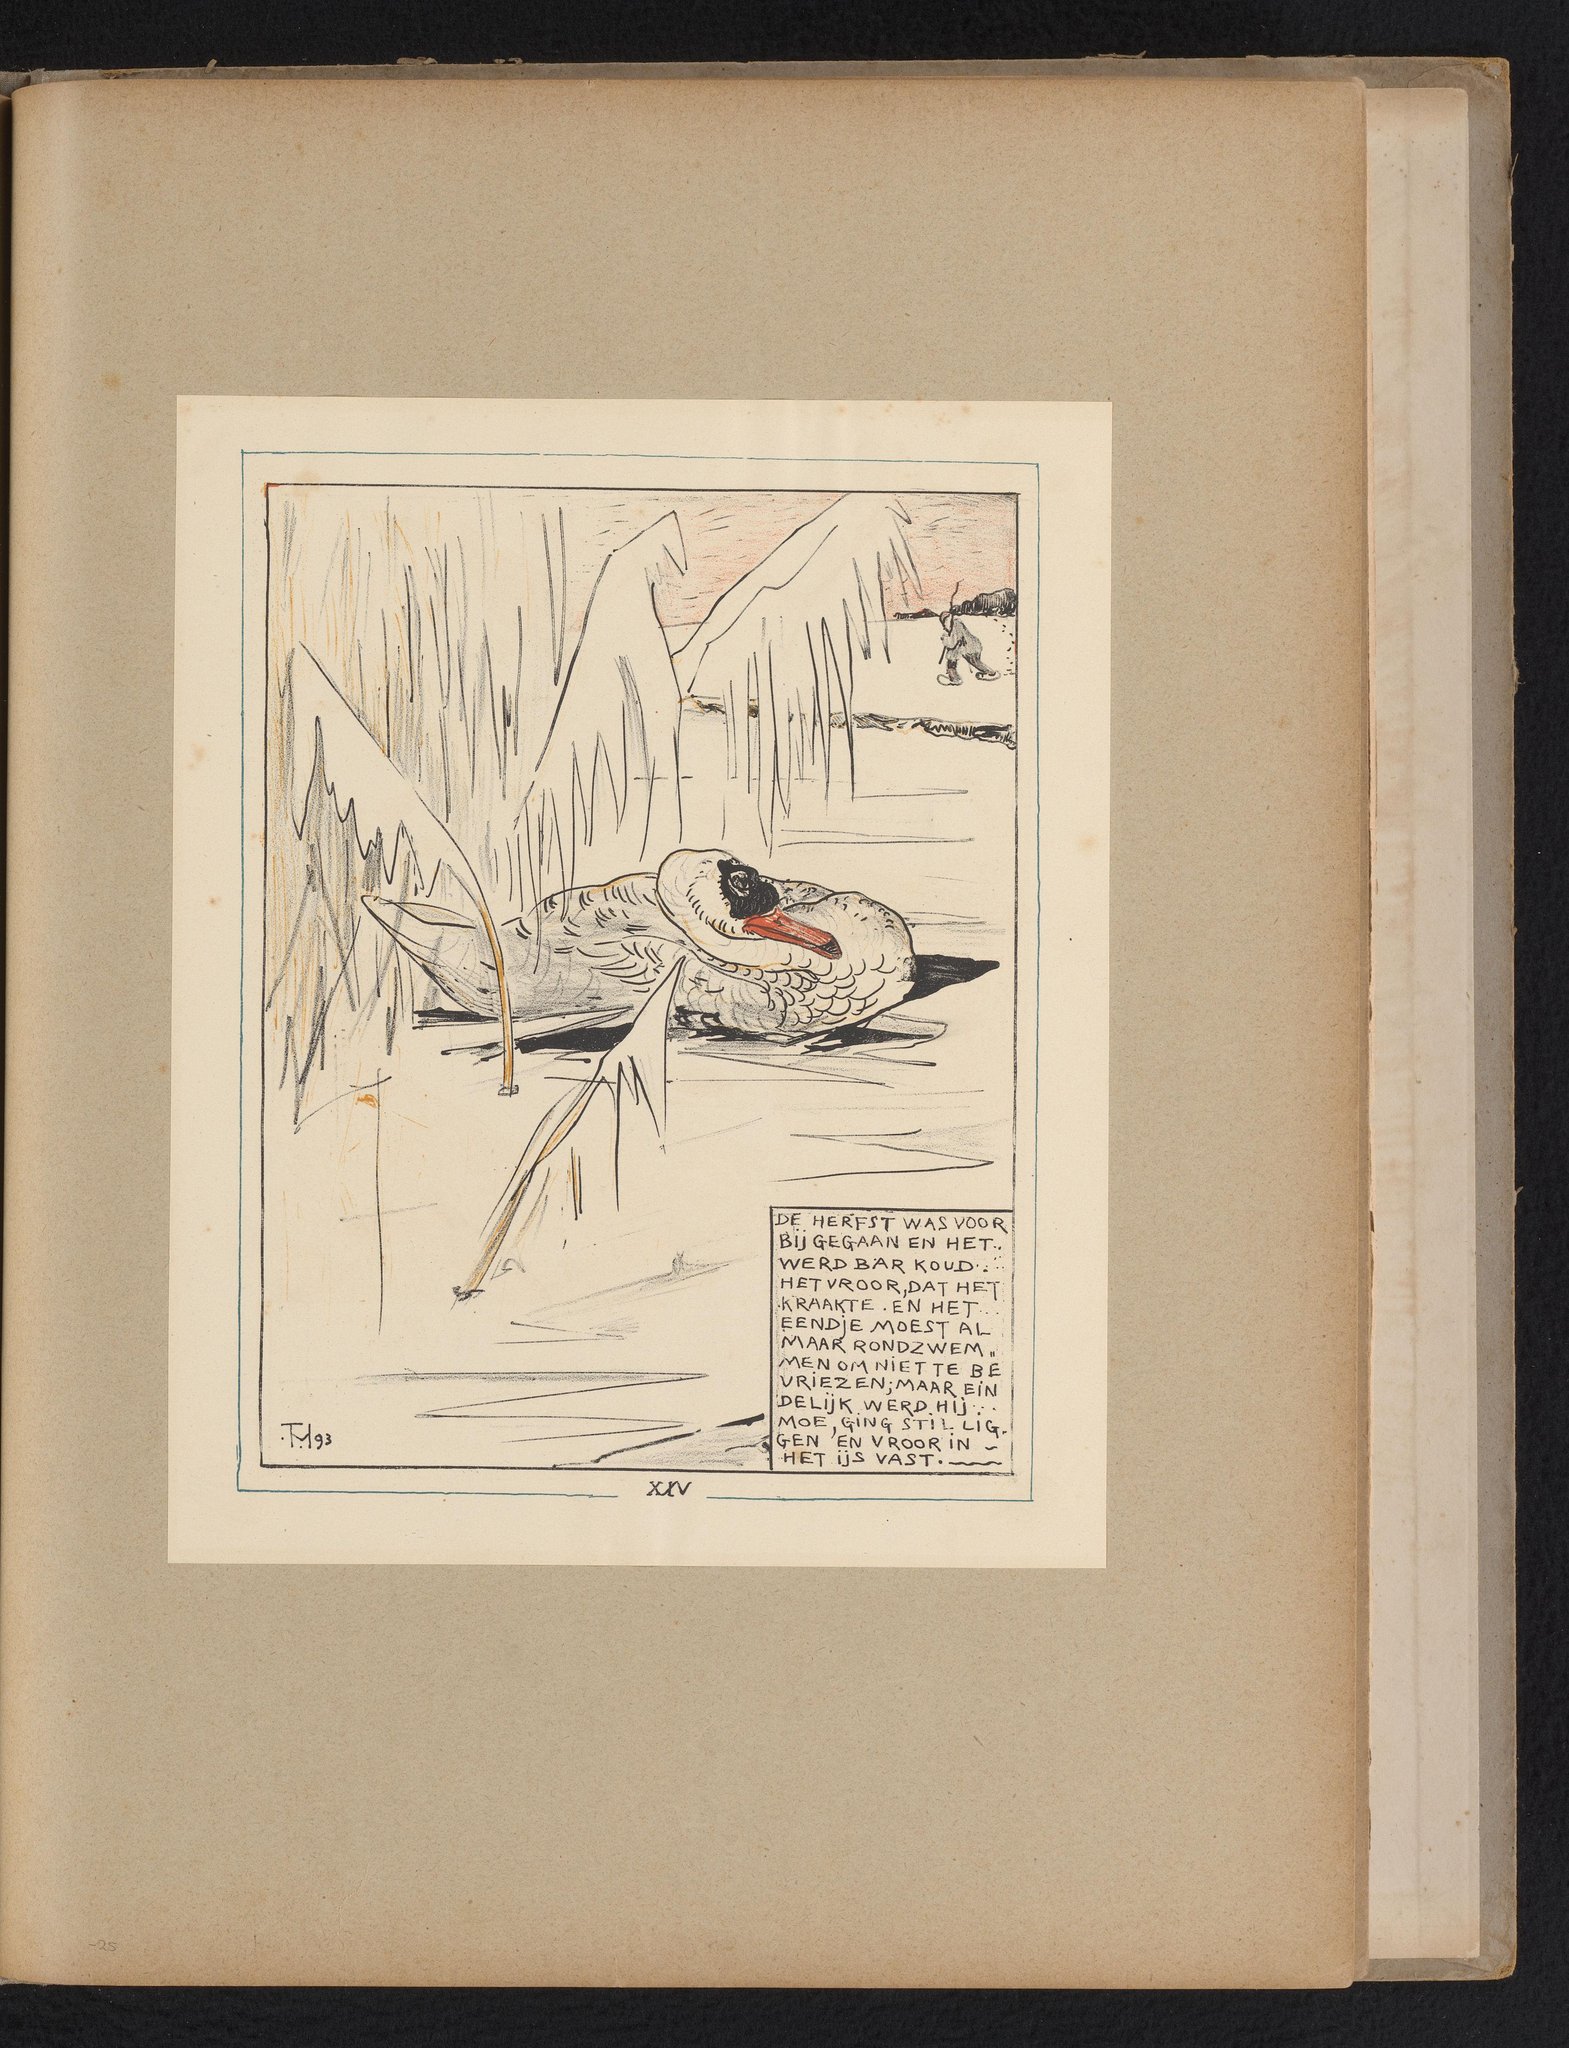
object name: album leaf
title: Zwaan vastgevroren in het ijs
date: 1893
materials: paper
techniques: lithograph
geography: the hague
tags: water-birds: swan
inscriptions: date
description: Deze prent maakt deel uit van een album.